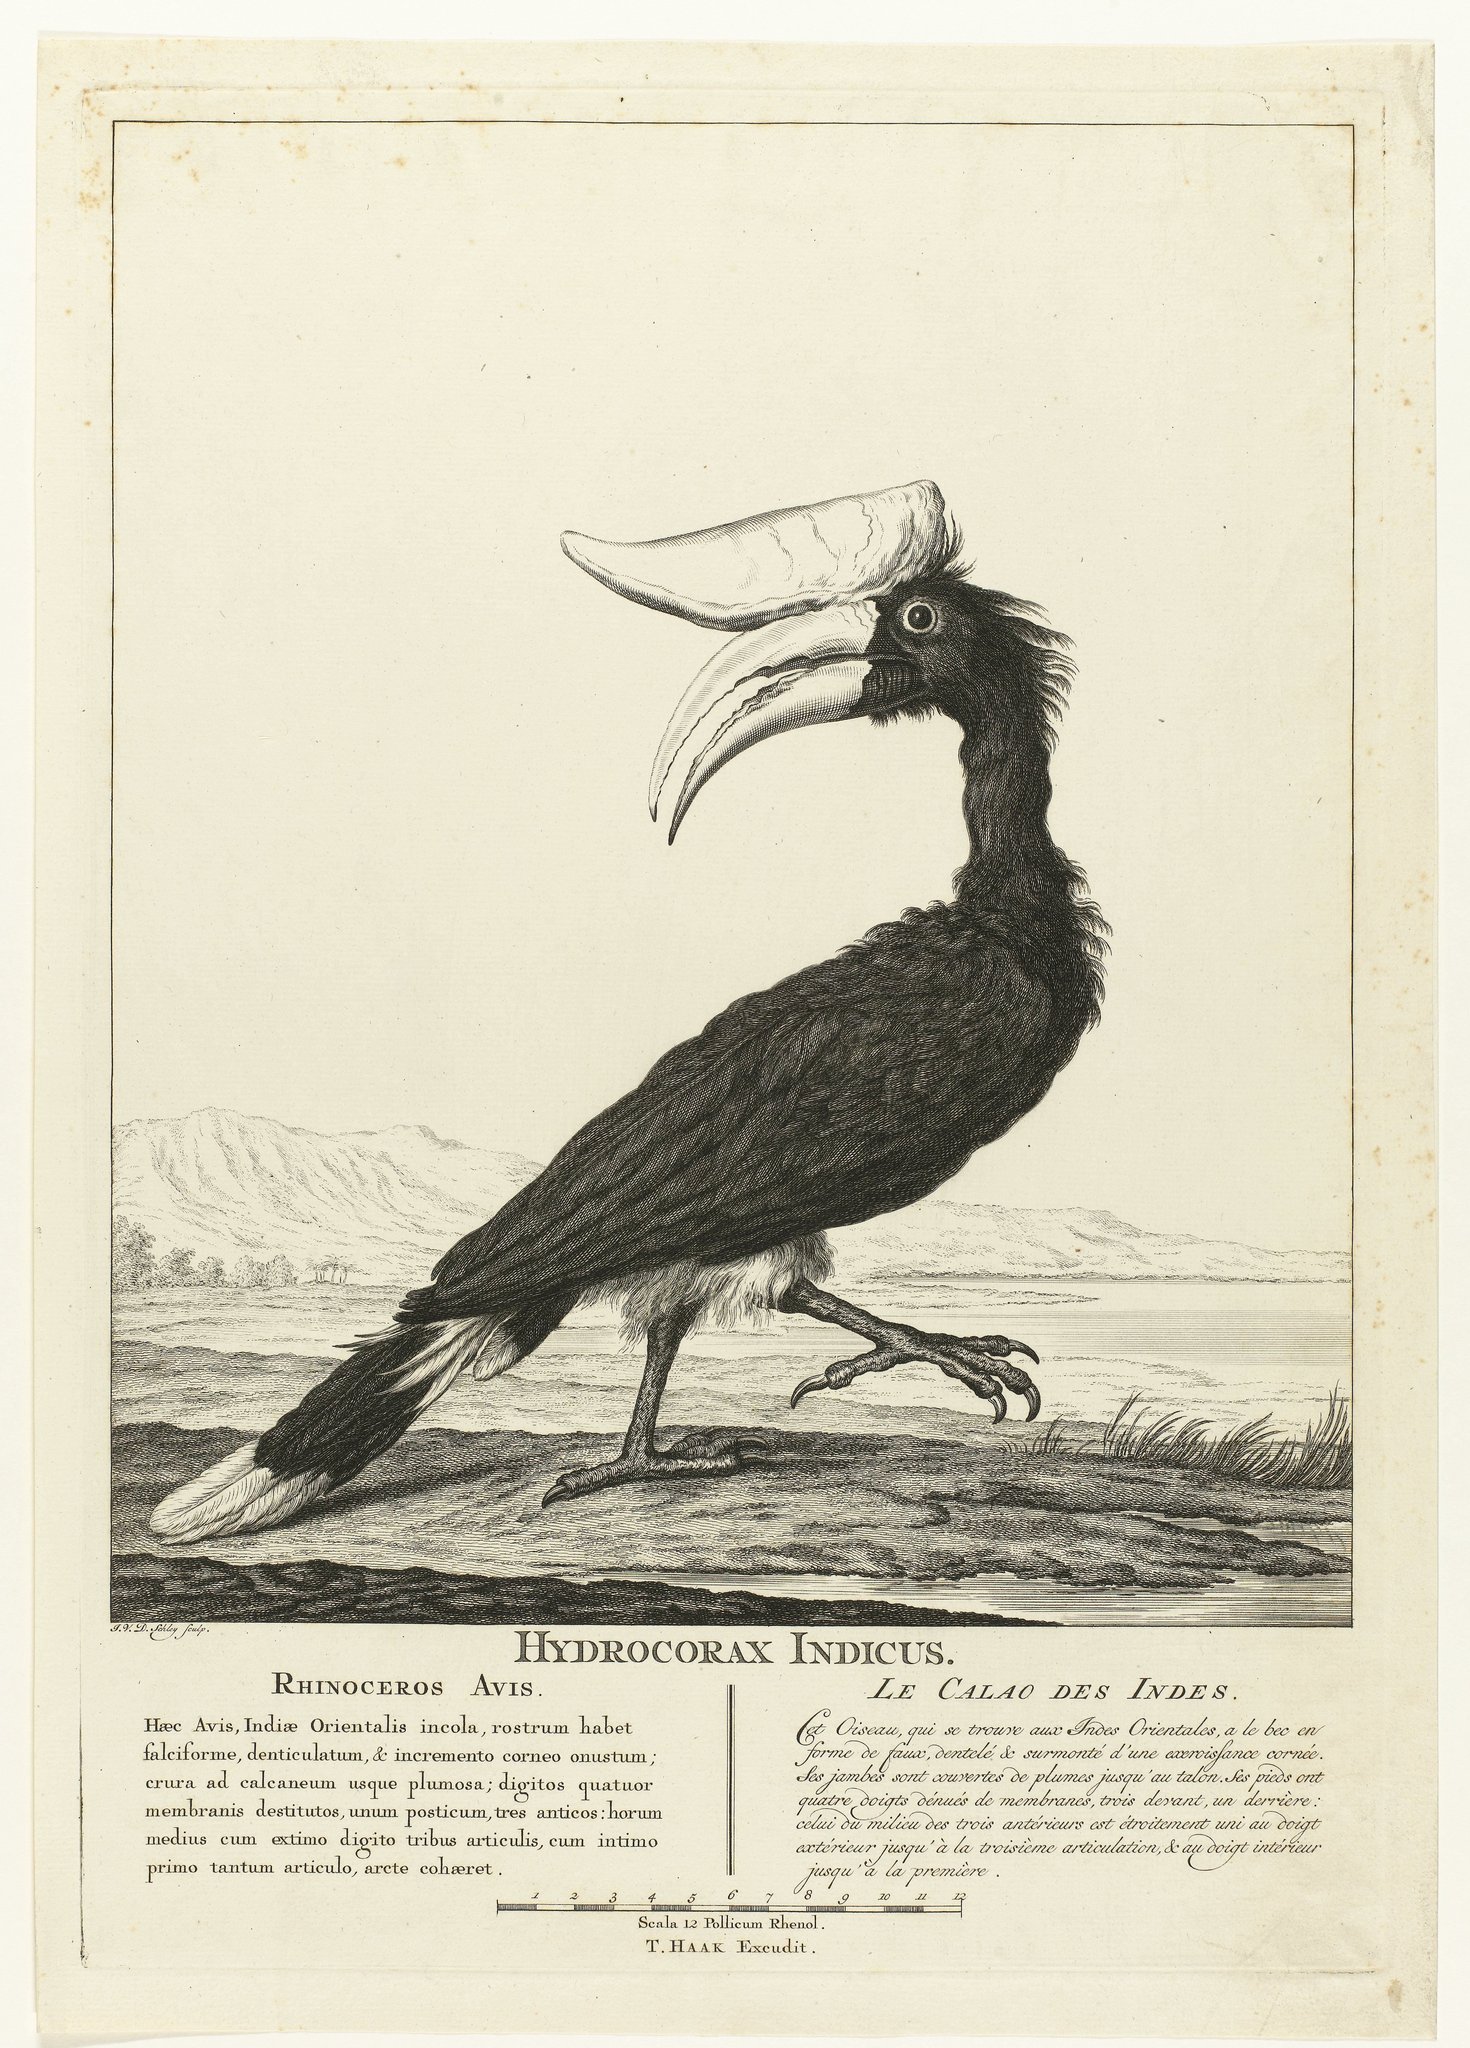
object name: print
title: Neushoornvogel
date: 1725-1779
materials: paper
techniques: engraving, etching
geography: amsterdam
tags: other birds: hornbill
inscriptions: collector's mark: Lugt 240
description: Neushoornvogel aan de waterkant. In de marge twee kolommen tekst en een schaalverdeling.